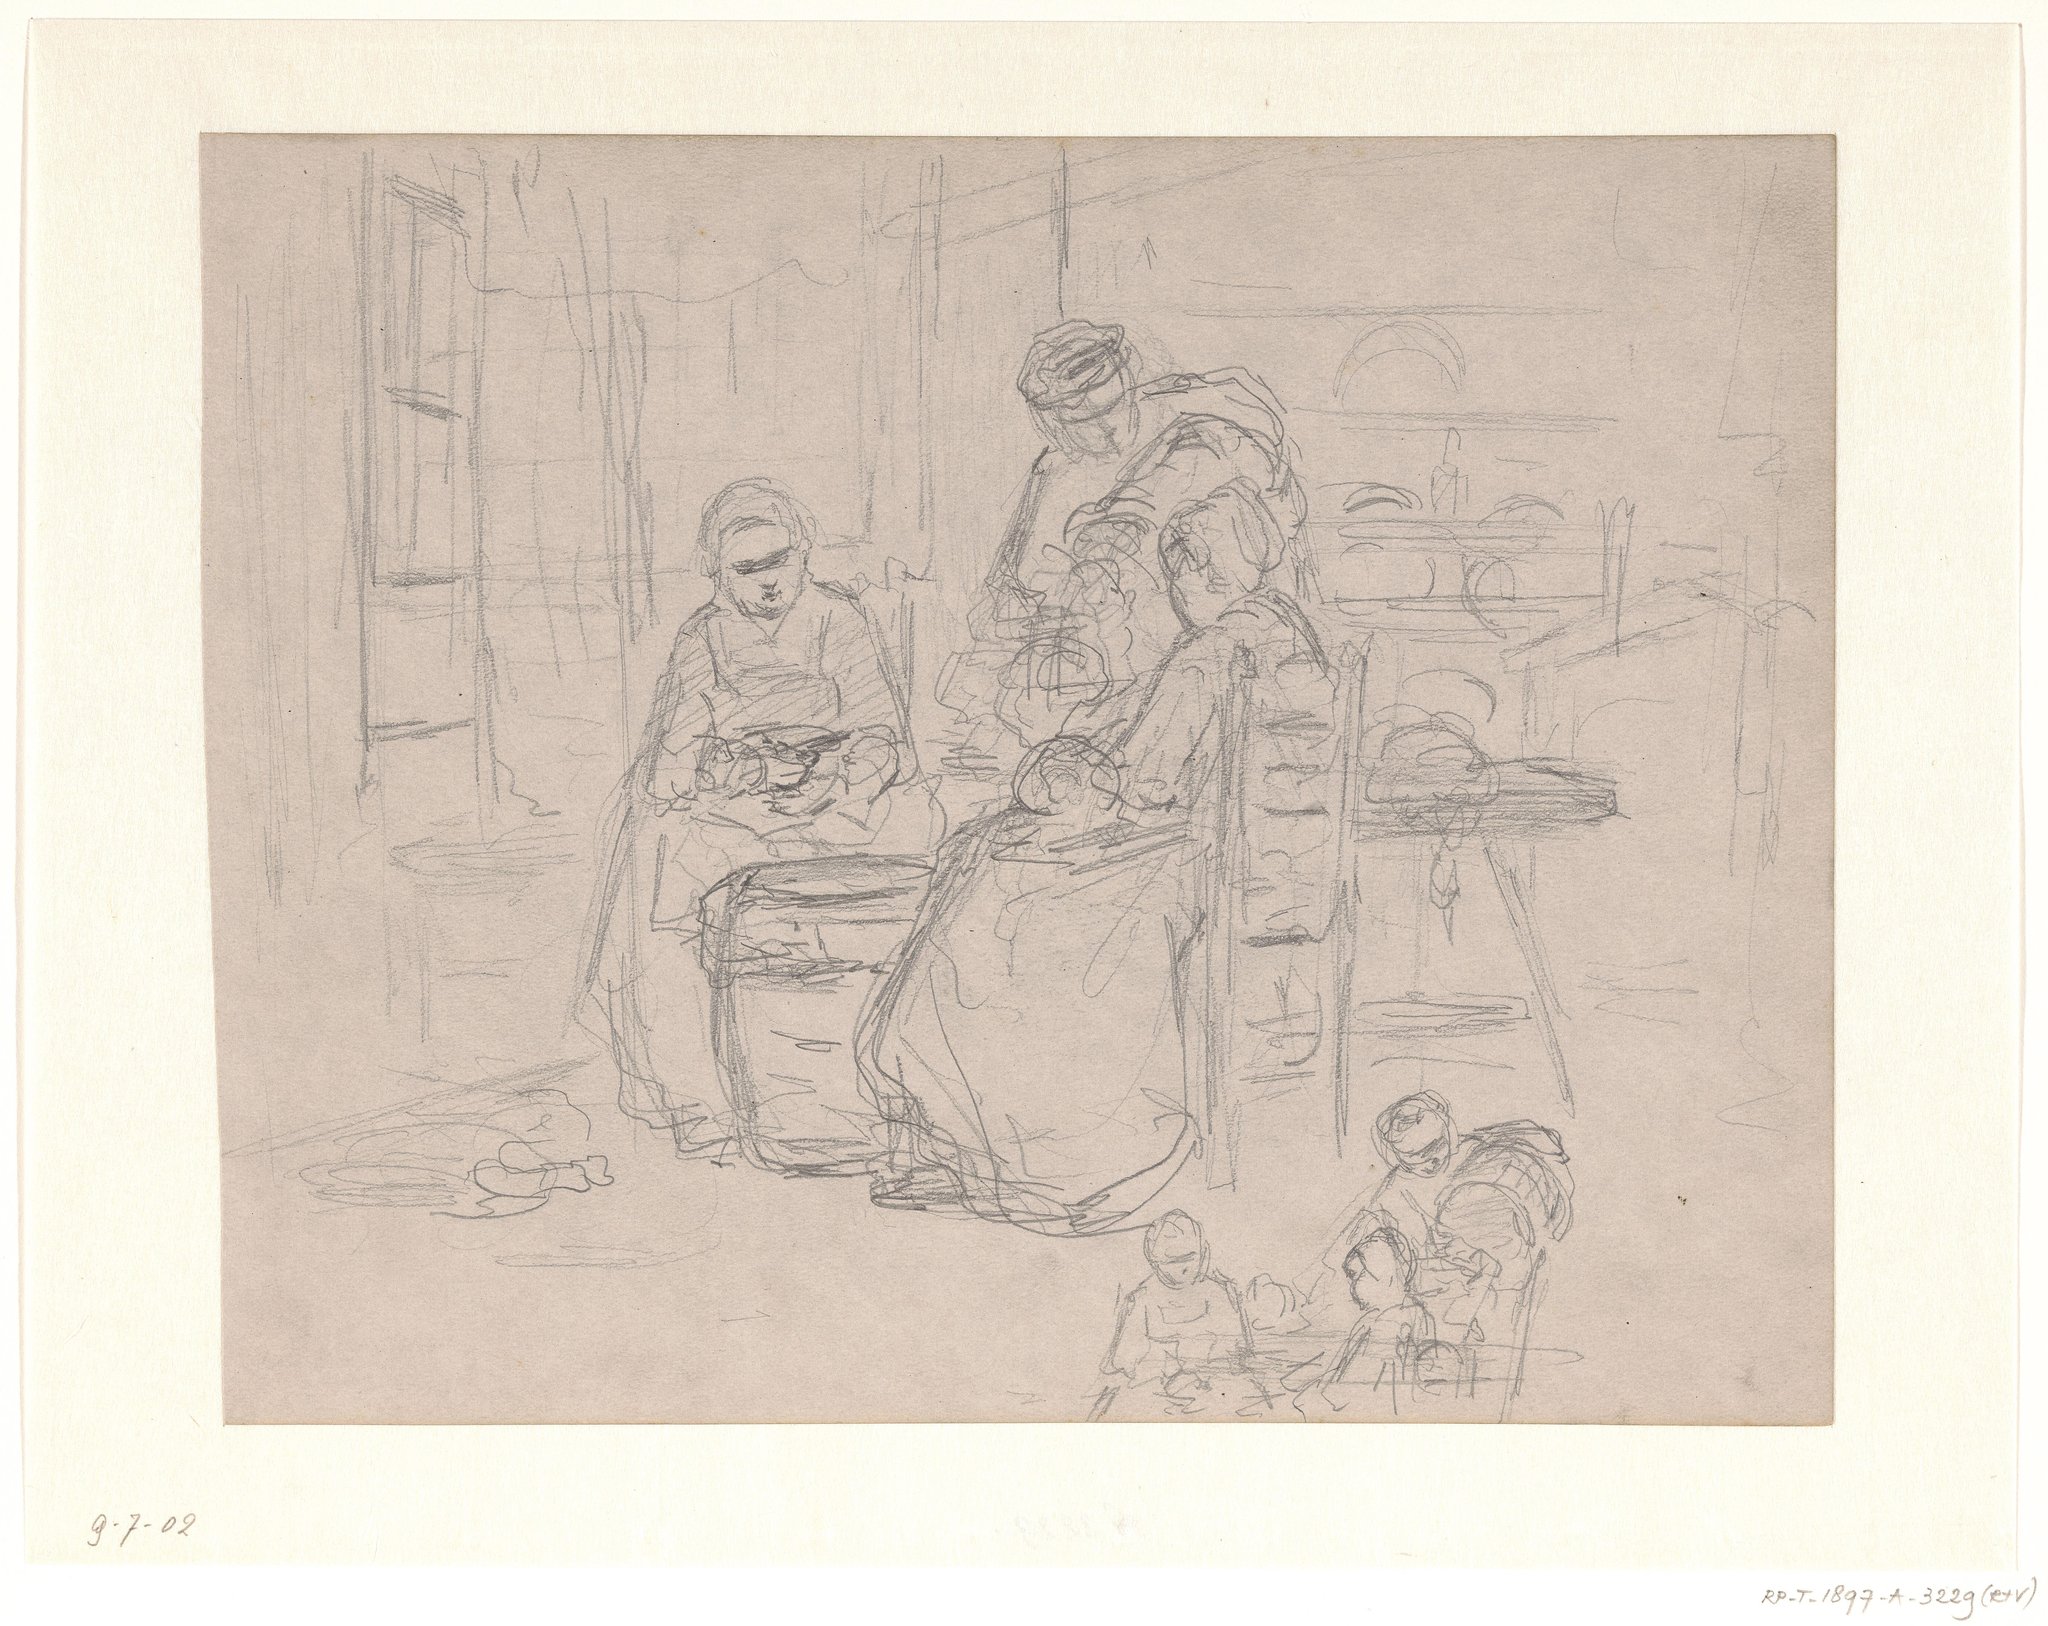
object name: drawing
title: Twee studies van vrouwen aan huishoudelijk werk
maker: hendrik valkenburg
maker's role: draughtsman, painter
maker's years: 1826-1896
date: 1836-1896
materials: chalk, paper, pencil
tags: interior of the house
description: Interieur met twee vrouwen aan huishoudelijk werk, rechtsonder een schets van dezelfde voorstelling.